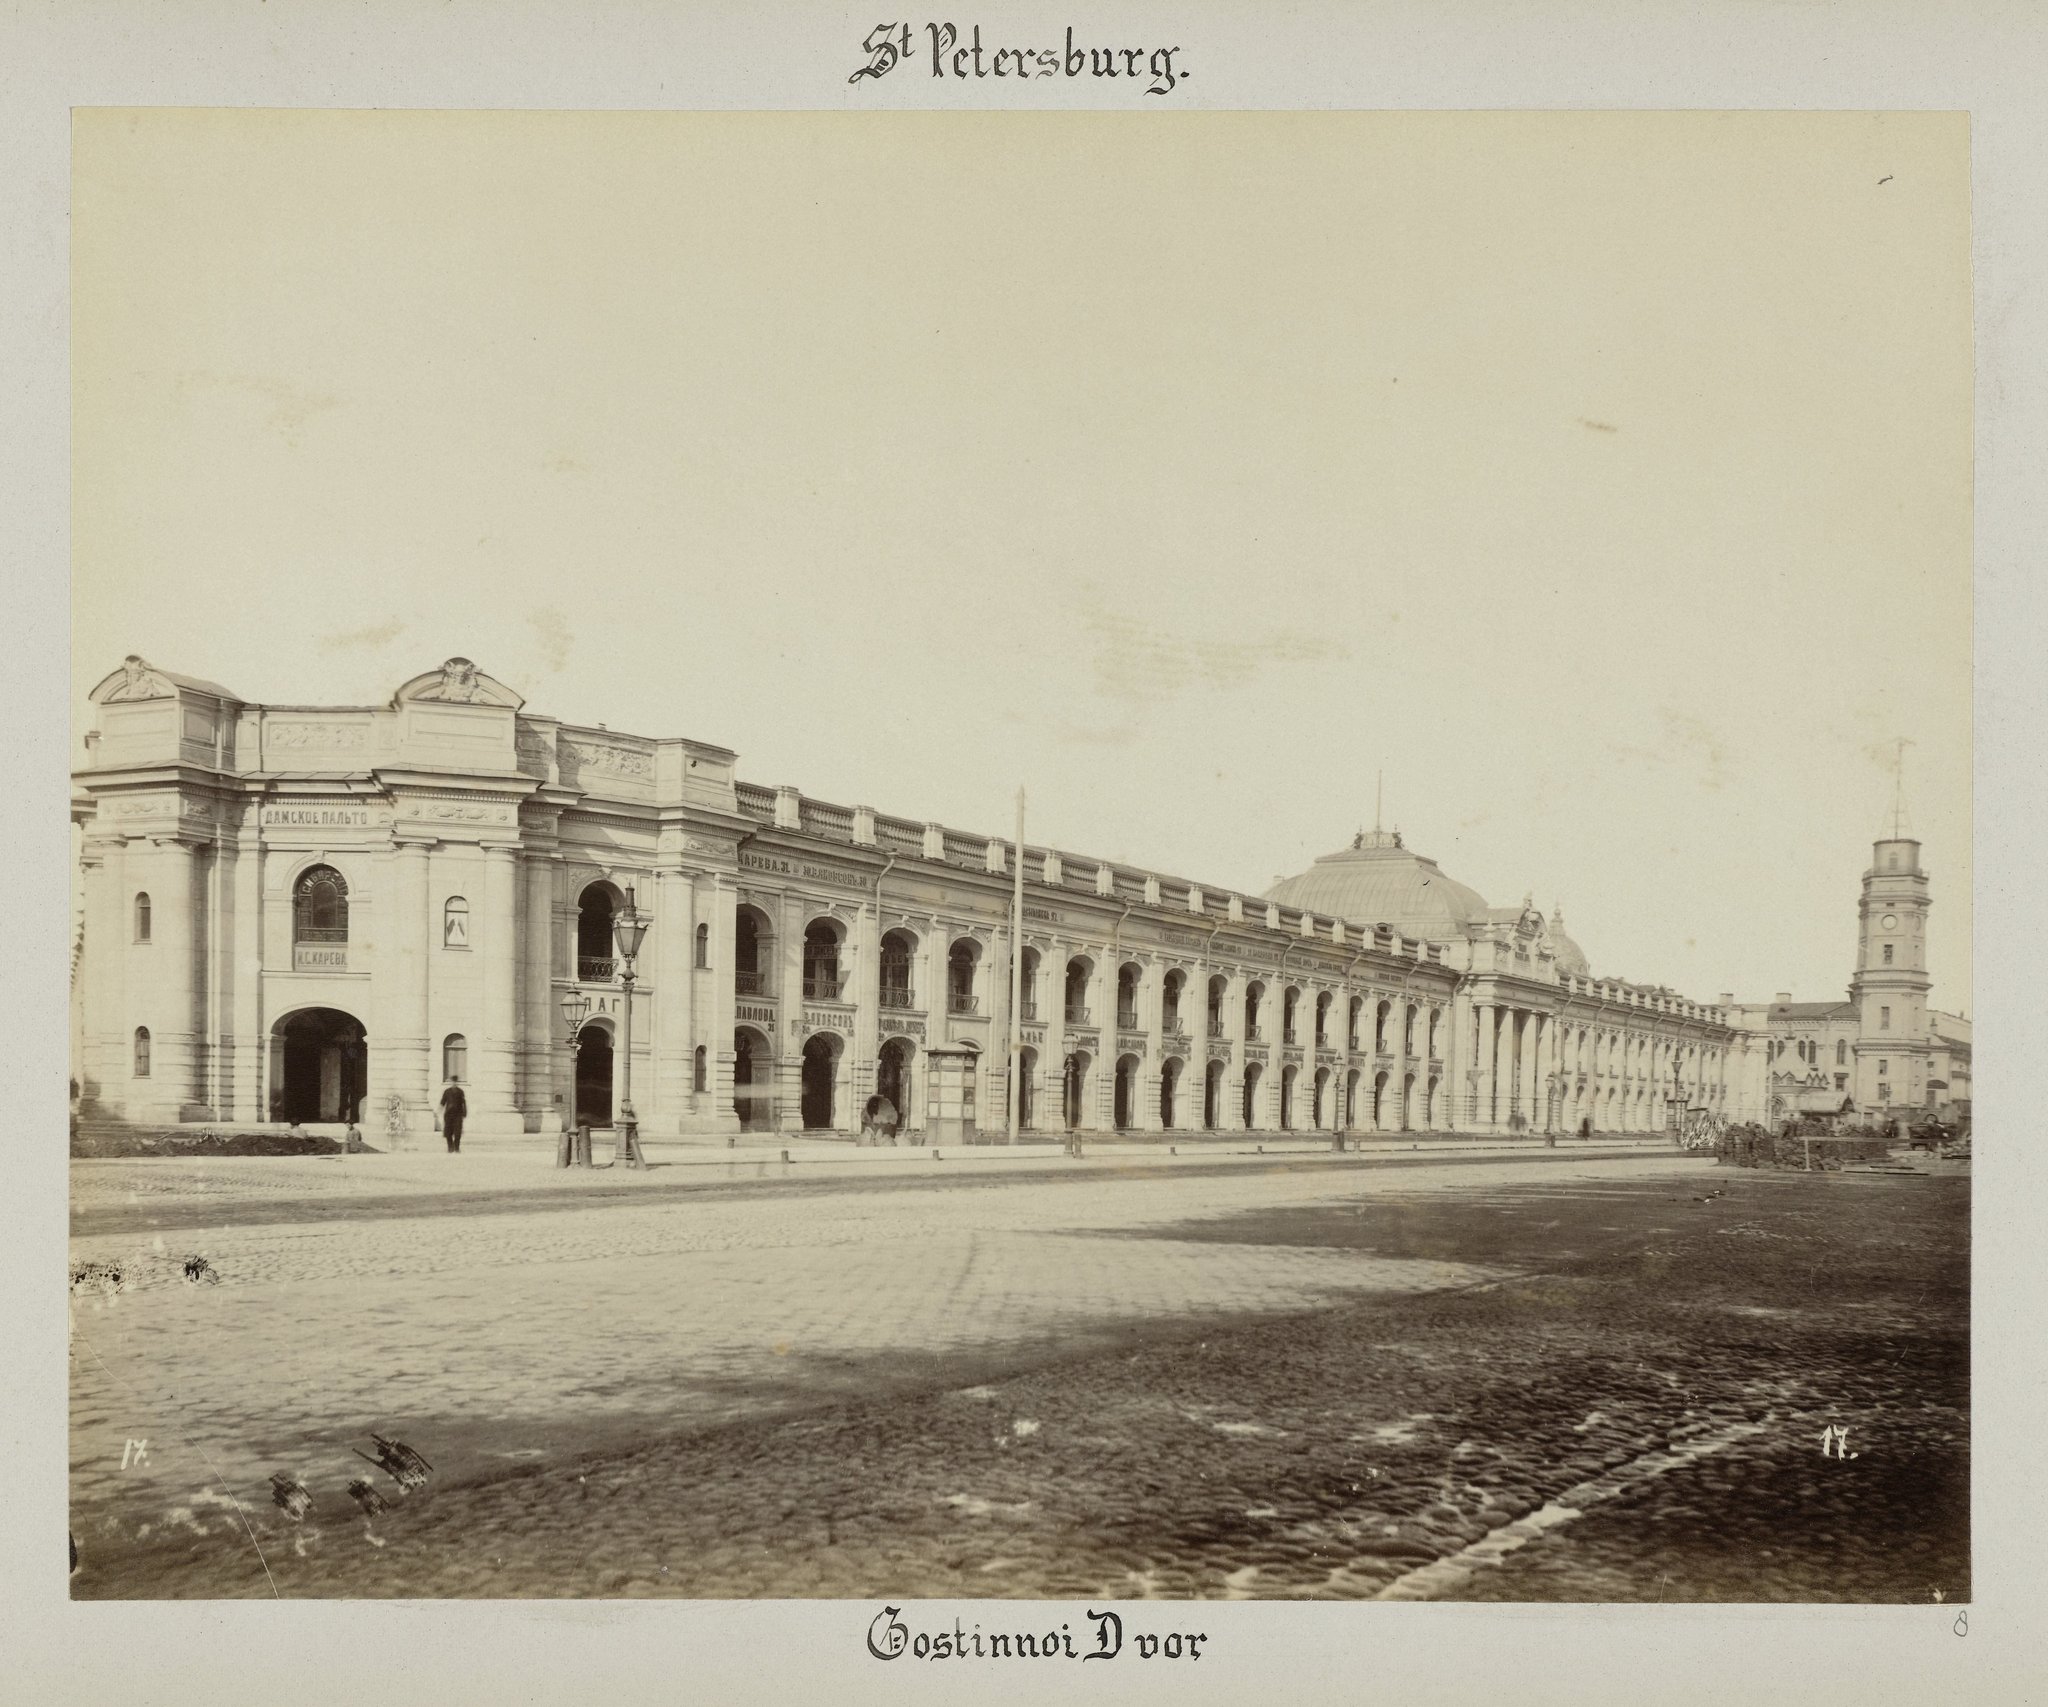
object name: photograph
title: Gostiny Dvor, het 18de-eeuwse warenhuis, aan de Nevski Prospekt in Sint Petersburg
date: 1898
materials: paper, photographic support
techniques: albumen print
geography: sint-petersburg